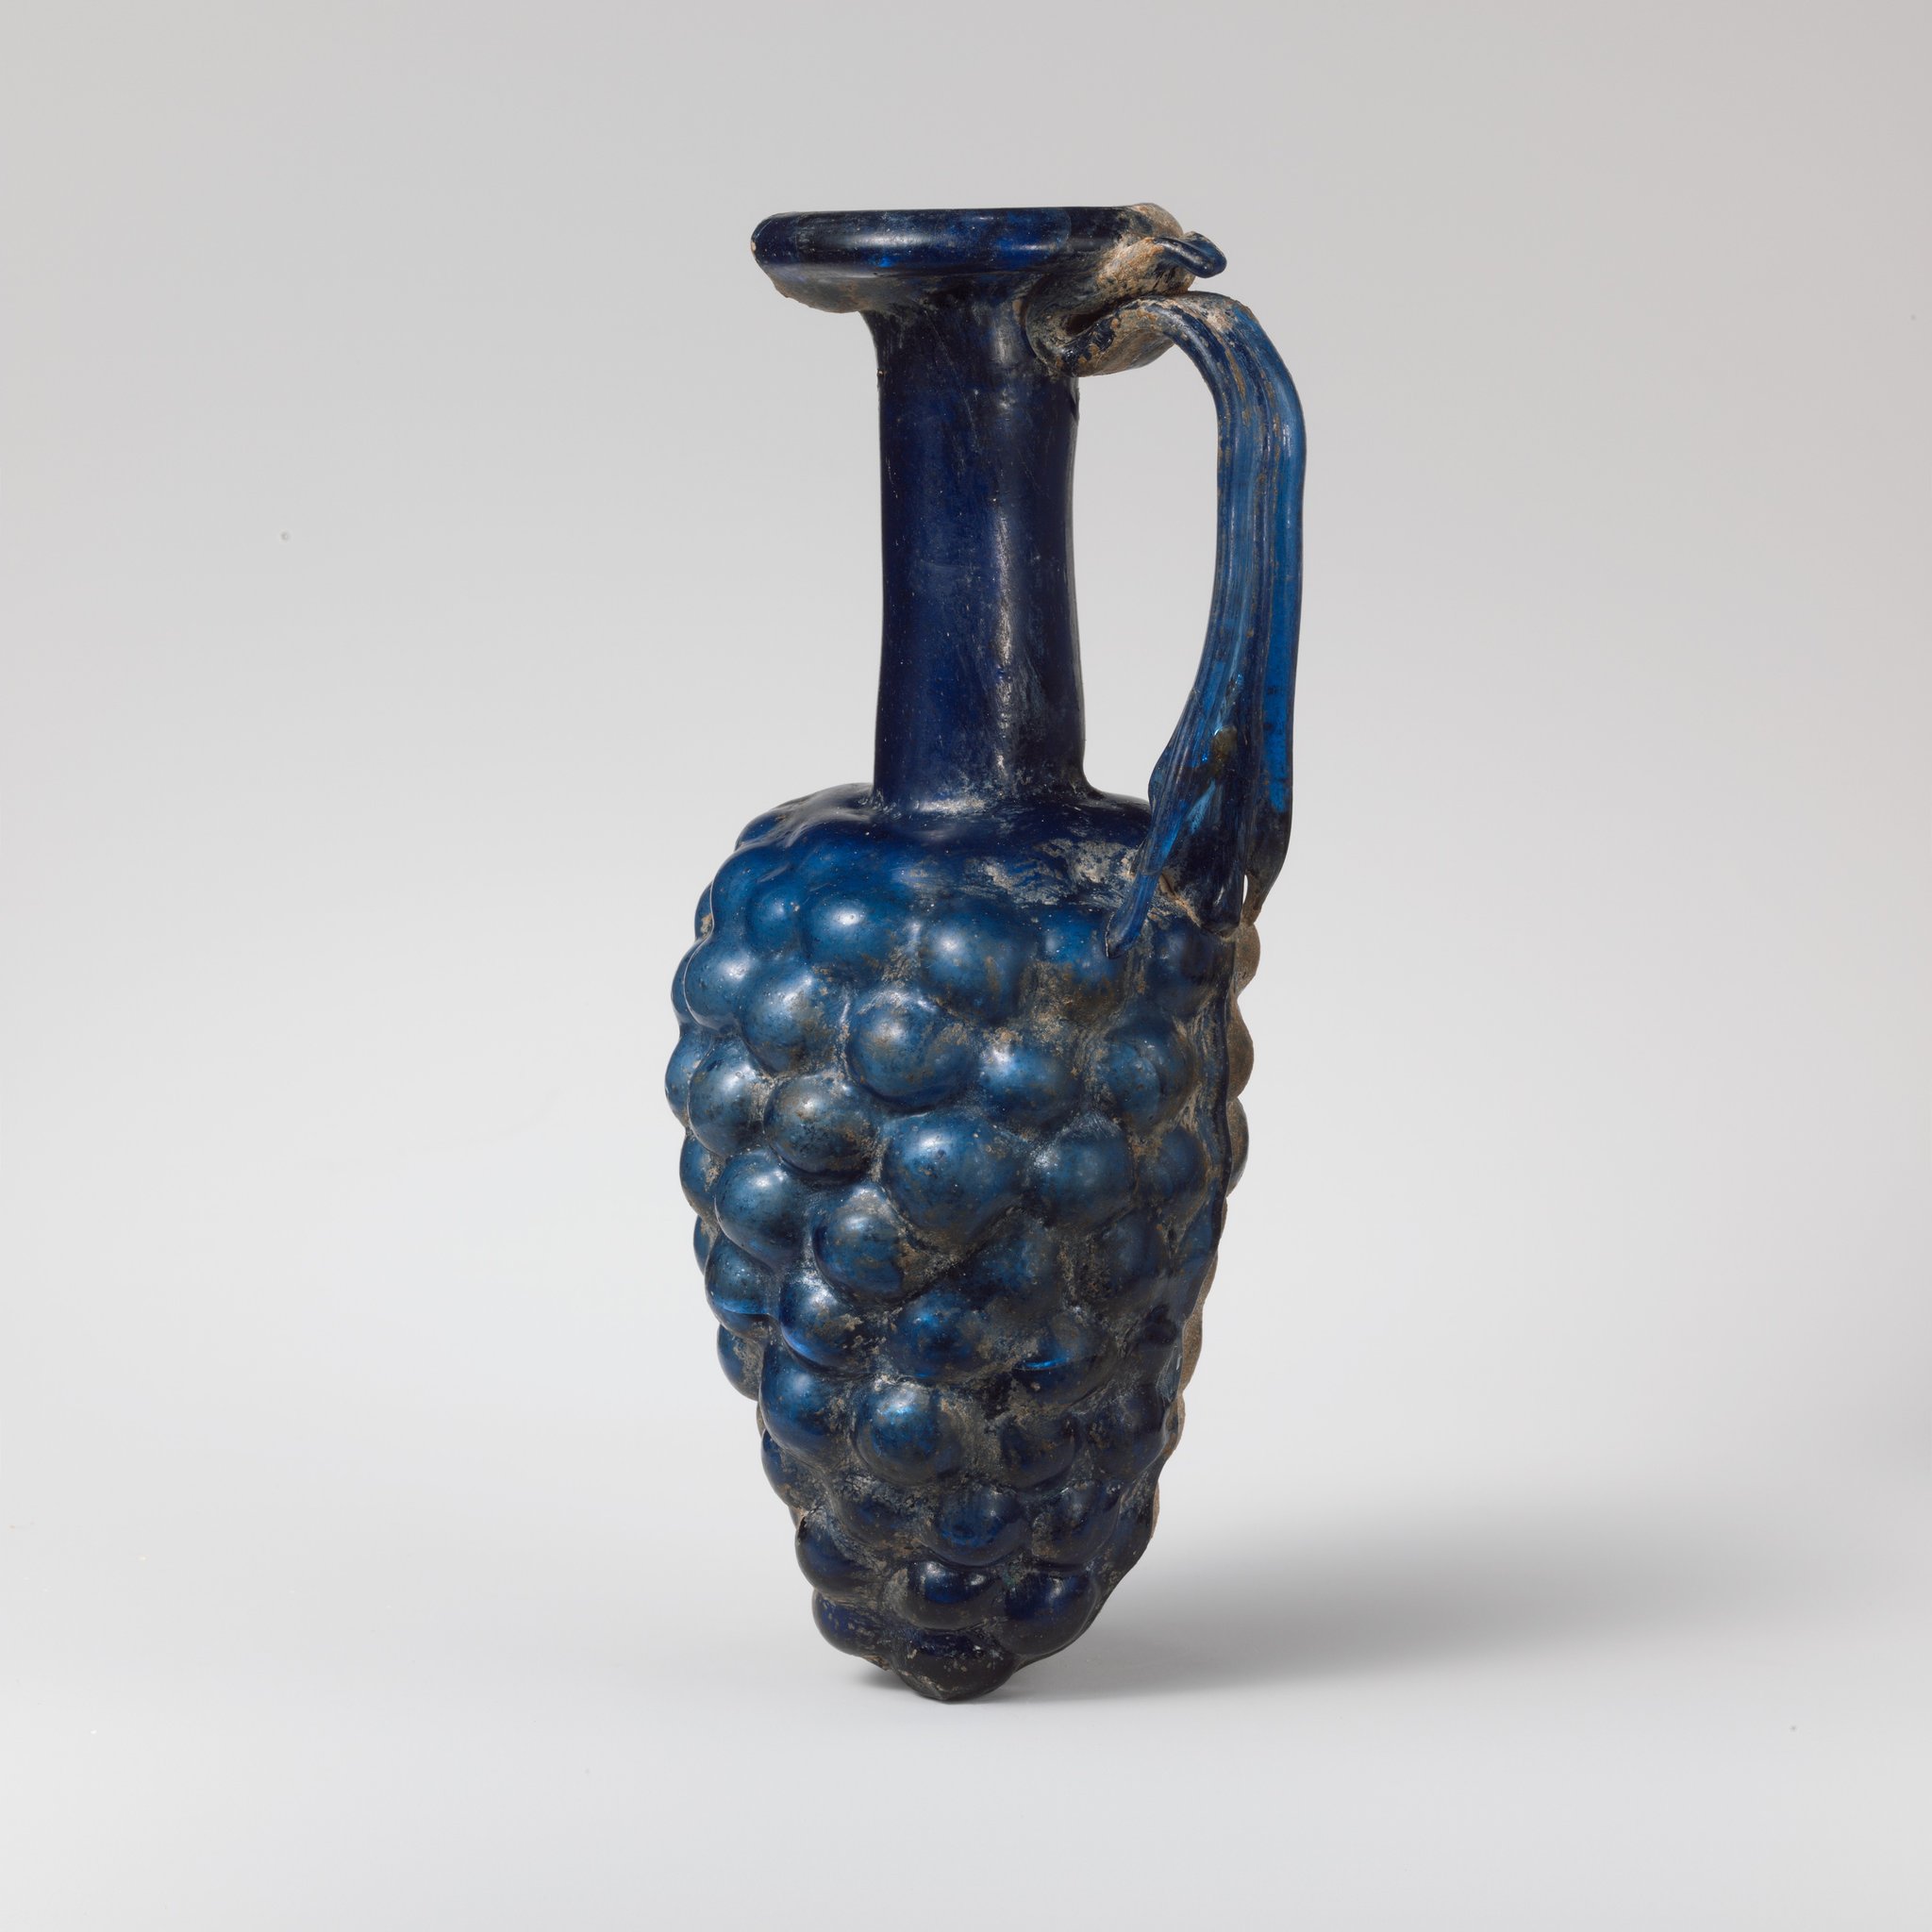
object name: jug with stylized grape cluster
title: Glass jug in the shape of a bunch of grapes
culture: roman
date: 201-300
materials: glass